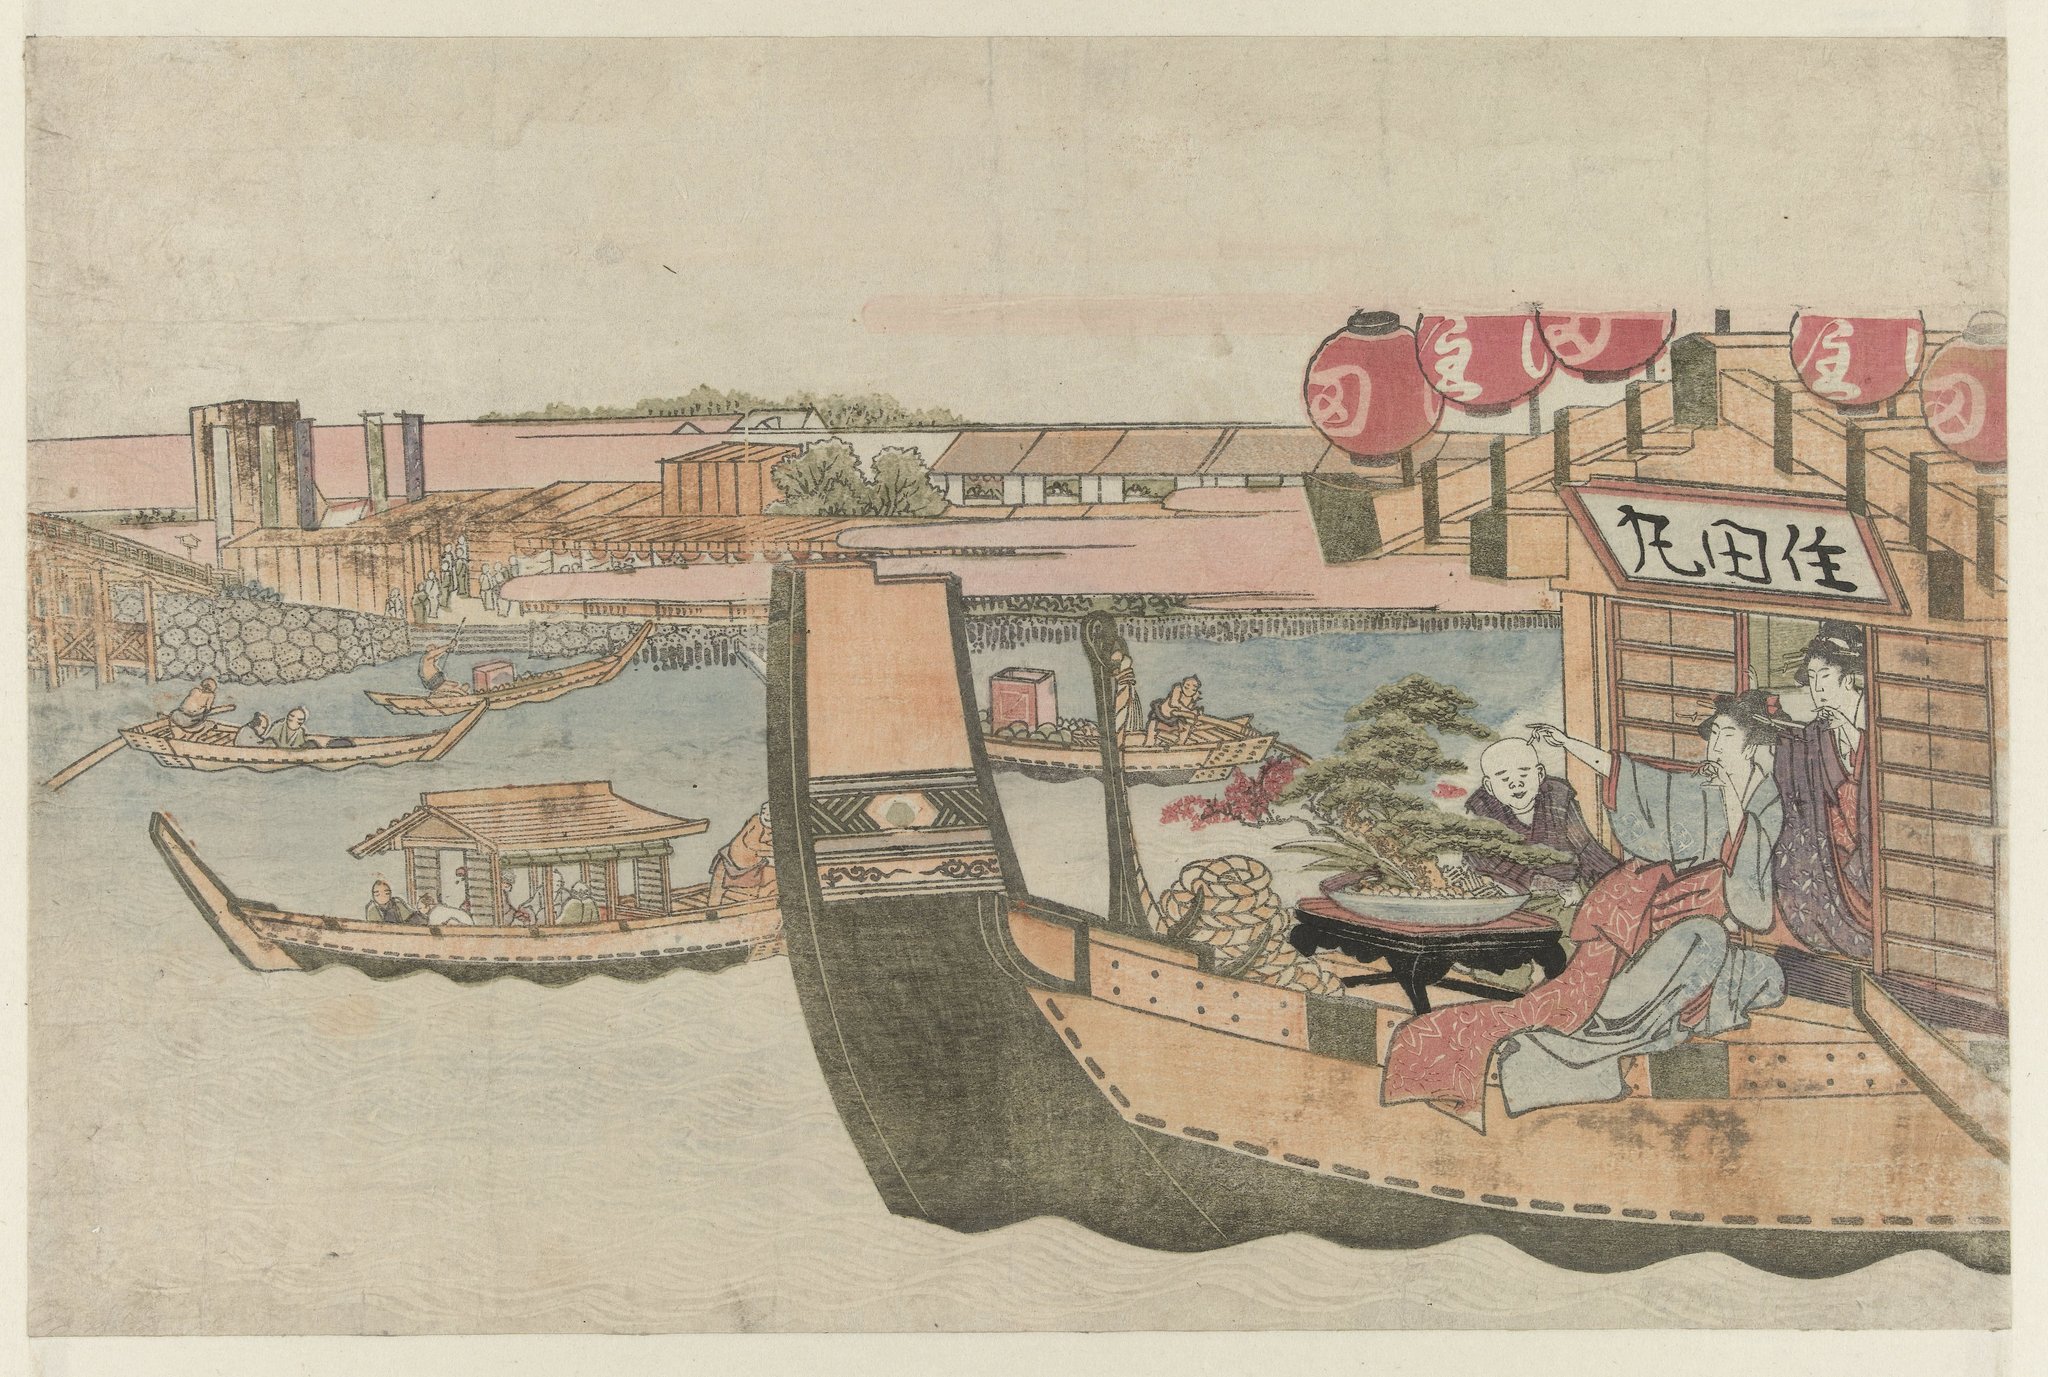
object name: print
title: Boating on Sumida river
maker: katsushika hokusai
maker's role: draughtsman, print maker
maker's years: 1760-1849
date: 1815-1820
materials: paper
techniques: blind stamped, woodcut, nishiki e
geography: japan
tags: river, rowing-boat, canoe, etc., lantern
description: Verschillende plezierboten op de rivier de Sumida. Op de voorgrond de punt van een boot, met twee vrouwen en een jongen, zittend bij een laag tafeltje waarop een bonsai boom staat. Op de achtergrond een gezicht op de rivieroever en een deel van de Ryogoku brug. De naam van de boot op de voorgrond luidt Sumidamaru.